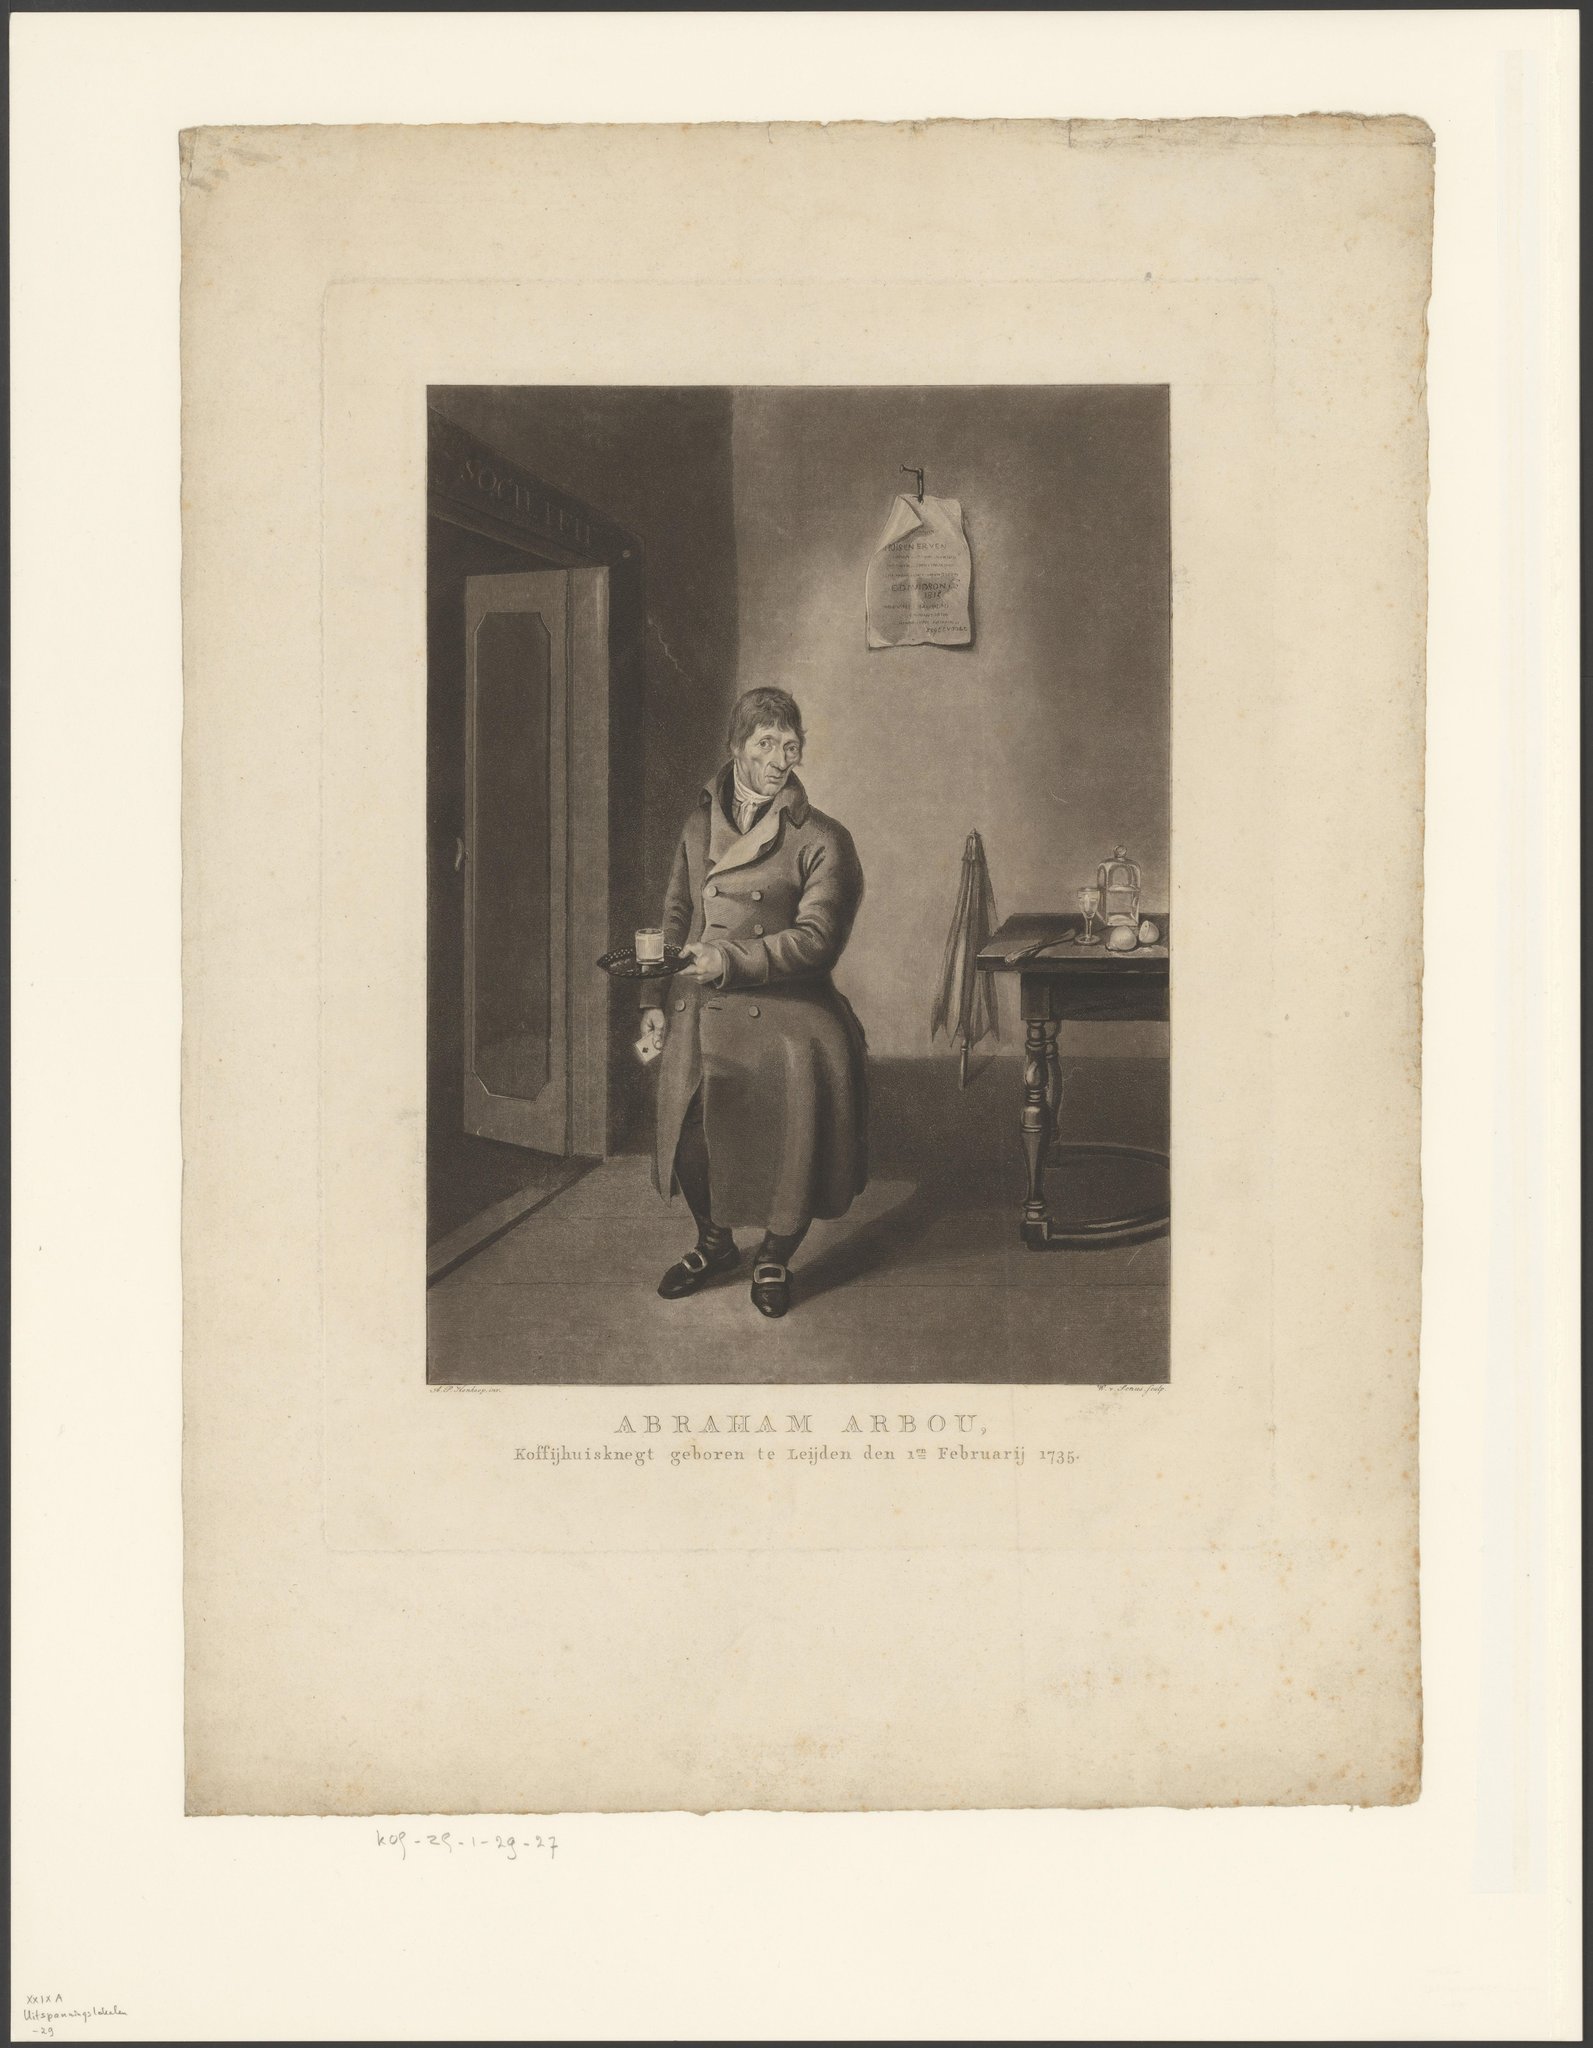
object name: print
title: Portret van Abraham Arbou, 1815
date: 1815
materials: paper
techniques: aquatint, etching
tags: leiden, historical persons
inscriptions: stamp: ‘R.W.P. de Vries’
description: Portret van Abraham Arbou, 50 jaar koffieknecht bij de kastelein Hoogstraten in de Studentensociëteit te Leiden. Knecht staande met een dienblad waarop een glas en met een spel kaarten in de andere hand. Boven de deur staat: Societeit. Onderwerpsrubrieken binnen de Atlas Zeden en Gewoonten: Zeden en gewoonten in engeren zin, Volksleven, Uitspanningslokalen, Koffiehuizen.